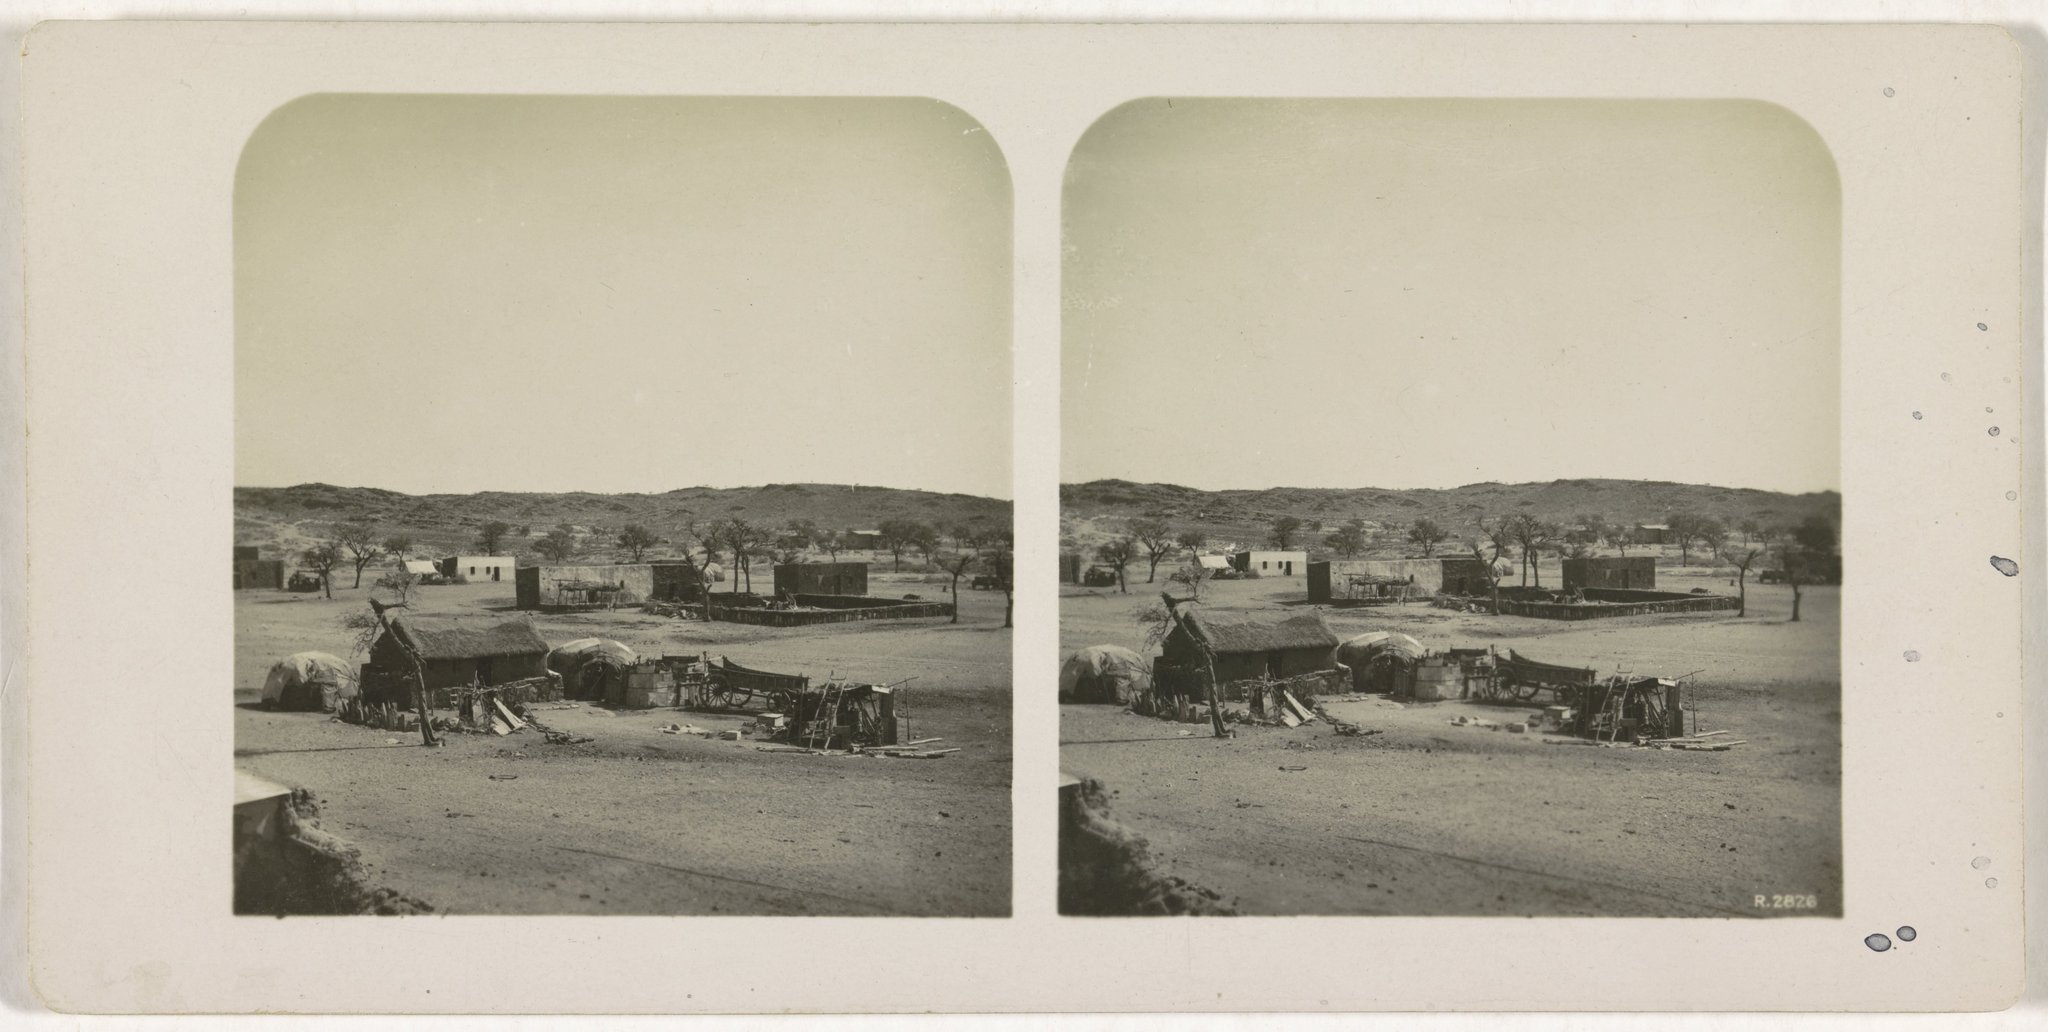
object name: stereograph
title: Gezicht op huisje in Rehoboth, Zuidwest-Afrika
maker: Anonymous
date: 1884-1914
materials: cardboard, paper, photographic support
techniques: gelatin silver print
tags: rehoboth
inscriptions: title: ‘Süd-West-Afrika / 2826. / Ein Amwesen in Rehobot / A cottage in Rehobot...’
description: Rechtsonder op de foto rechts staat: R.2826.